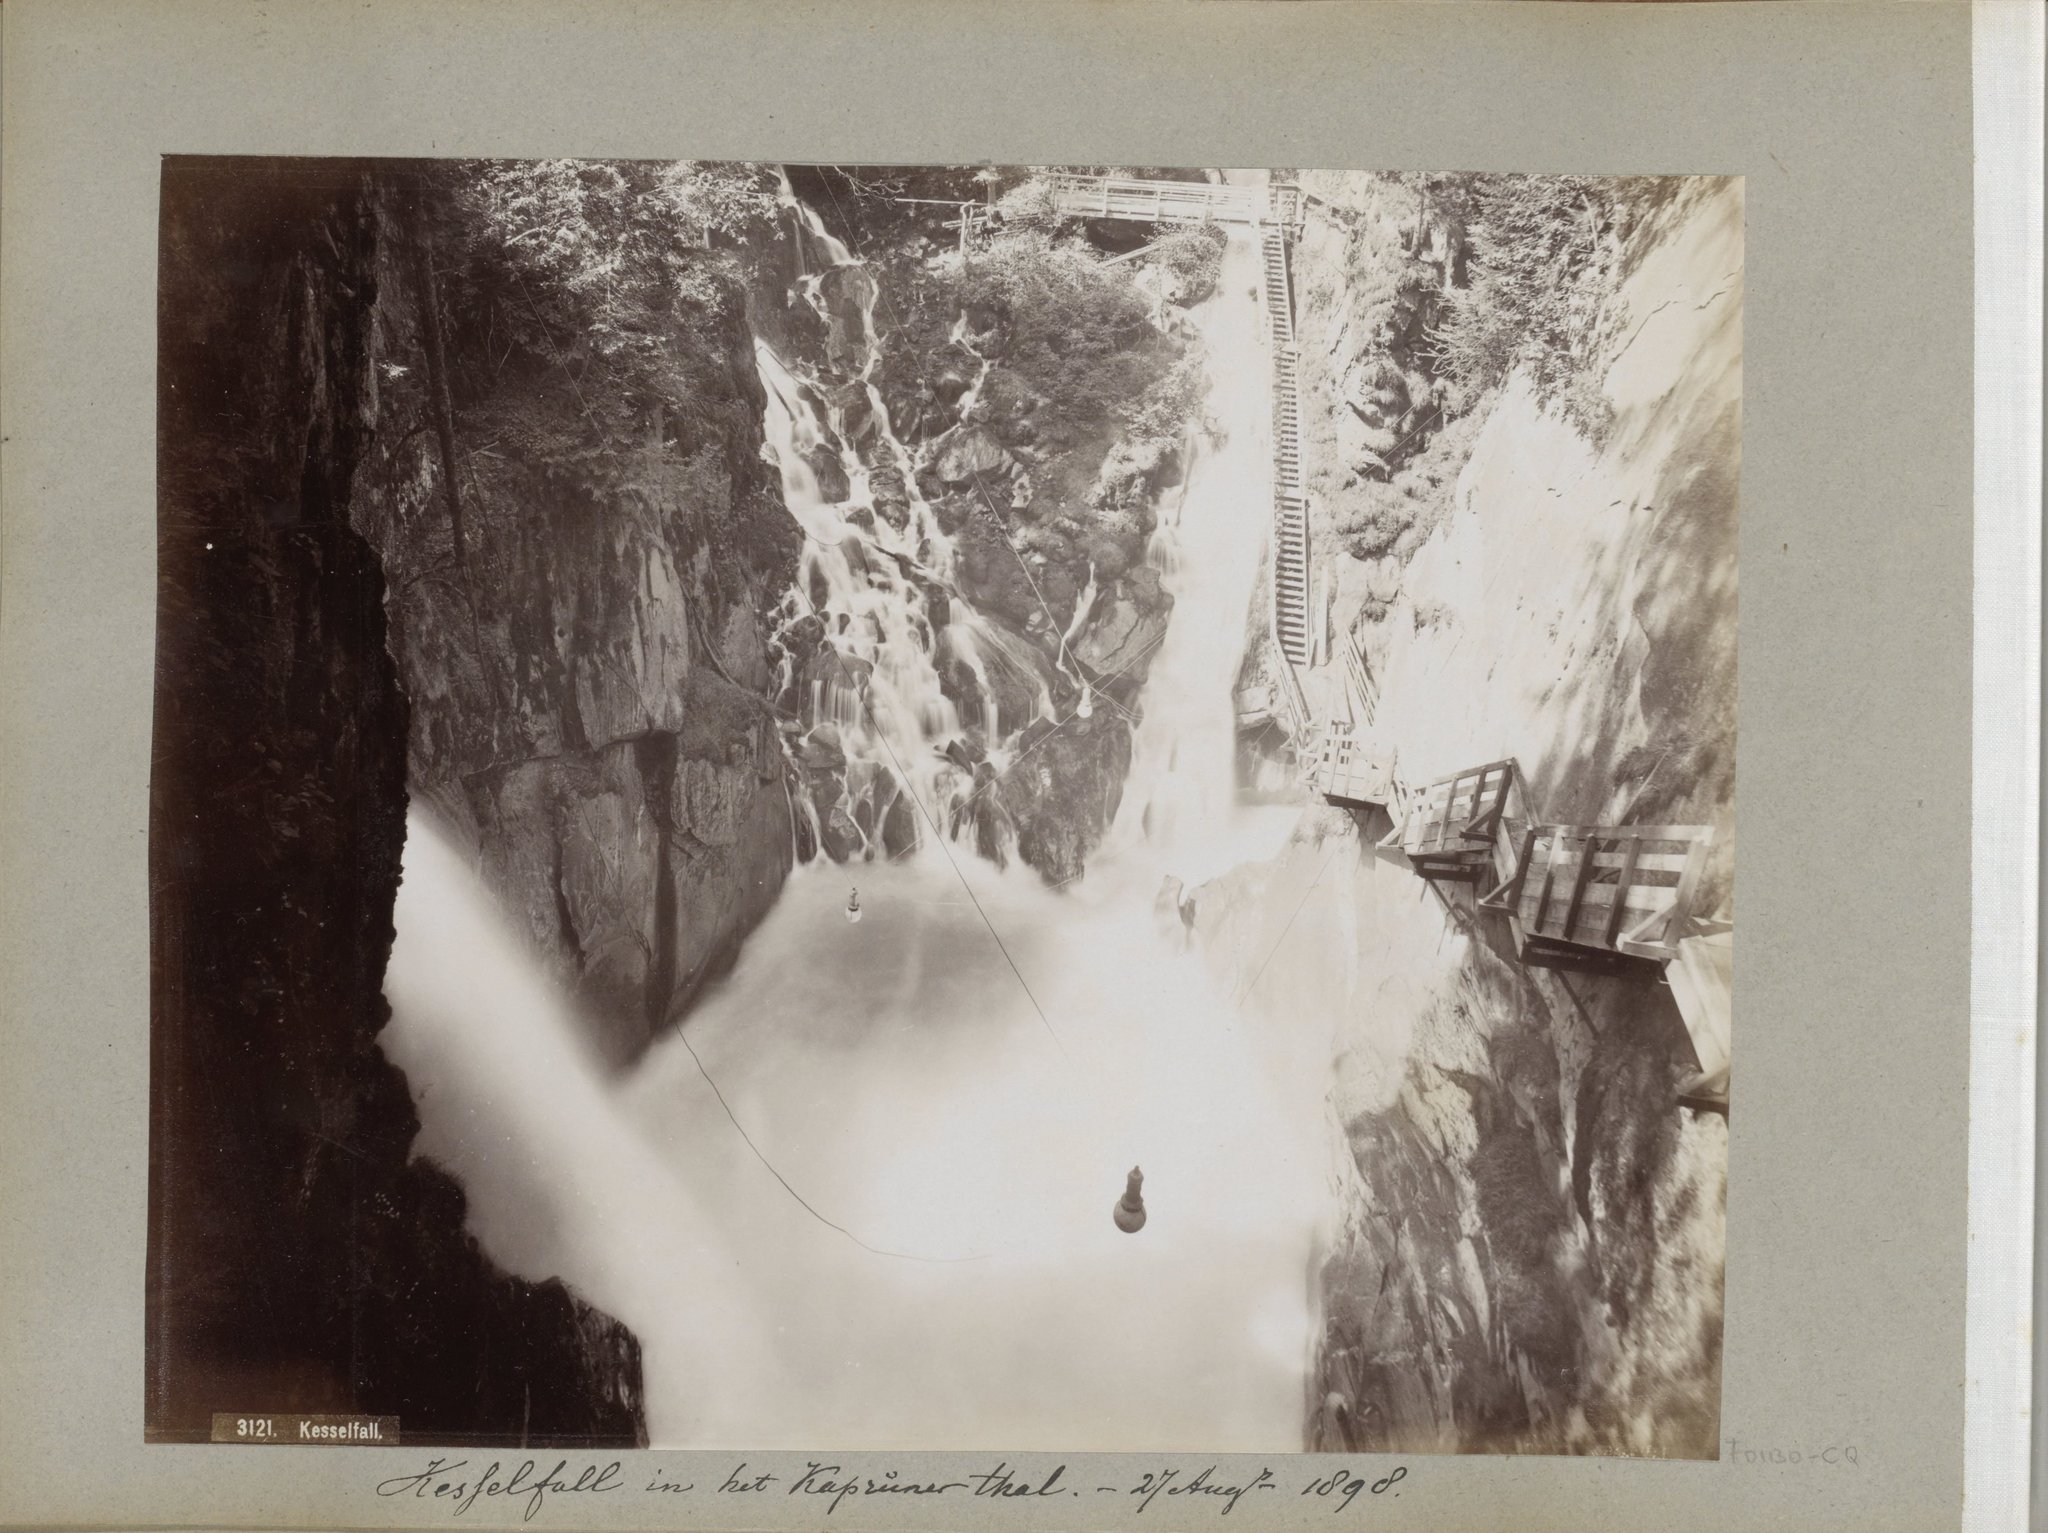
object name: photograph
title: Kesselfall.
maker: Anonymous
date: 1880-1898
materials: paper, photographic support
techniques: albumen print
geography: salzburg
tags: waterfall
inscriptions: negative number: ‘3121’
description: Onderdeel van Reisalbum met foto's van bezienswaardigheden in Frankrijk, Spanje, Italië, Duitsland, Zwitserland en Oostenrijk.